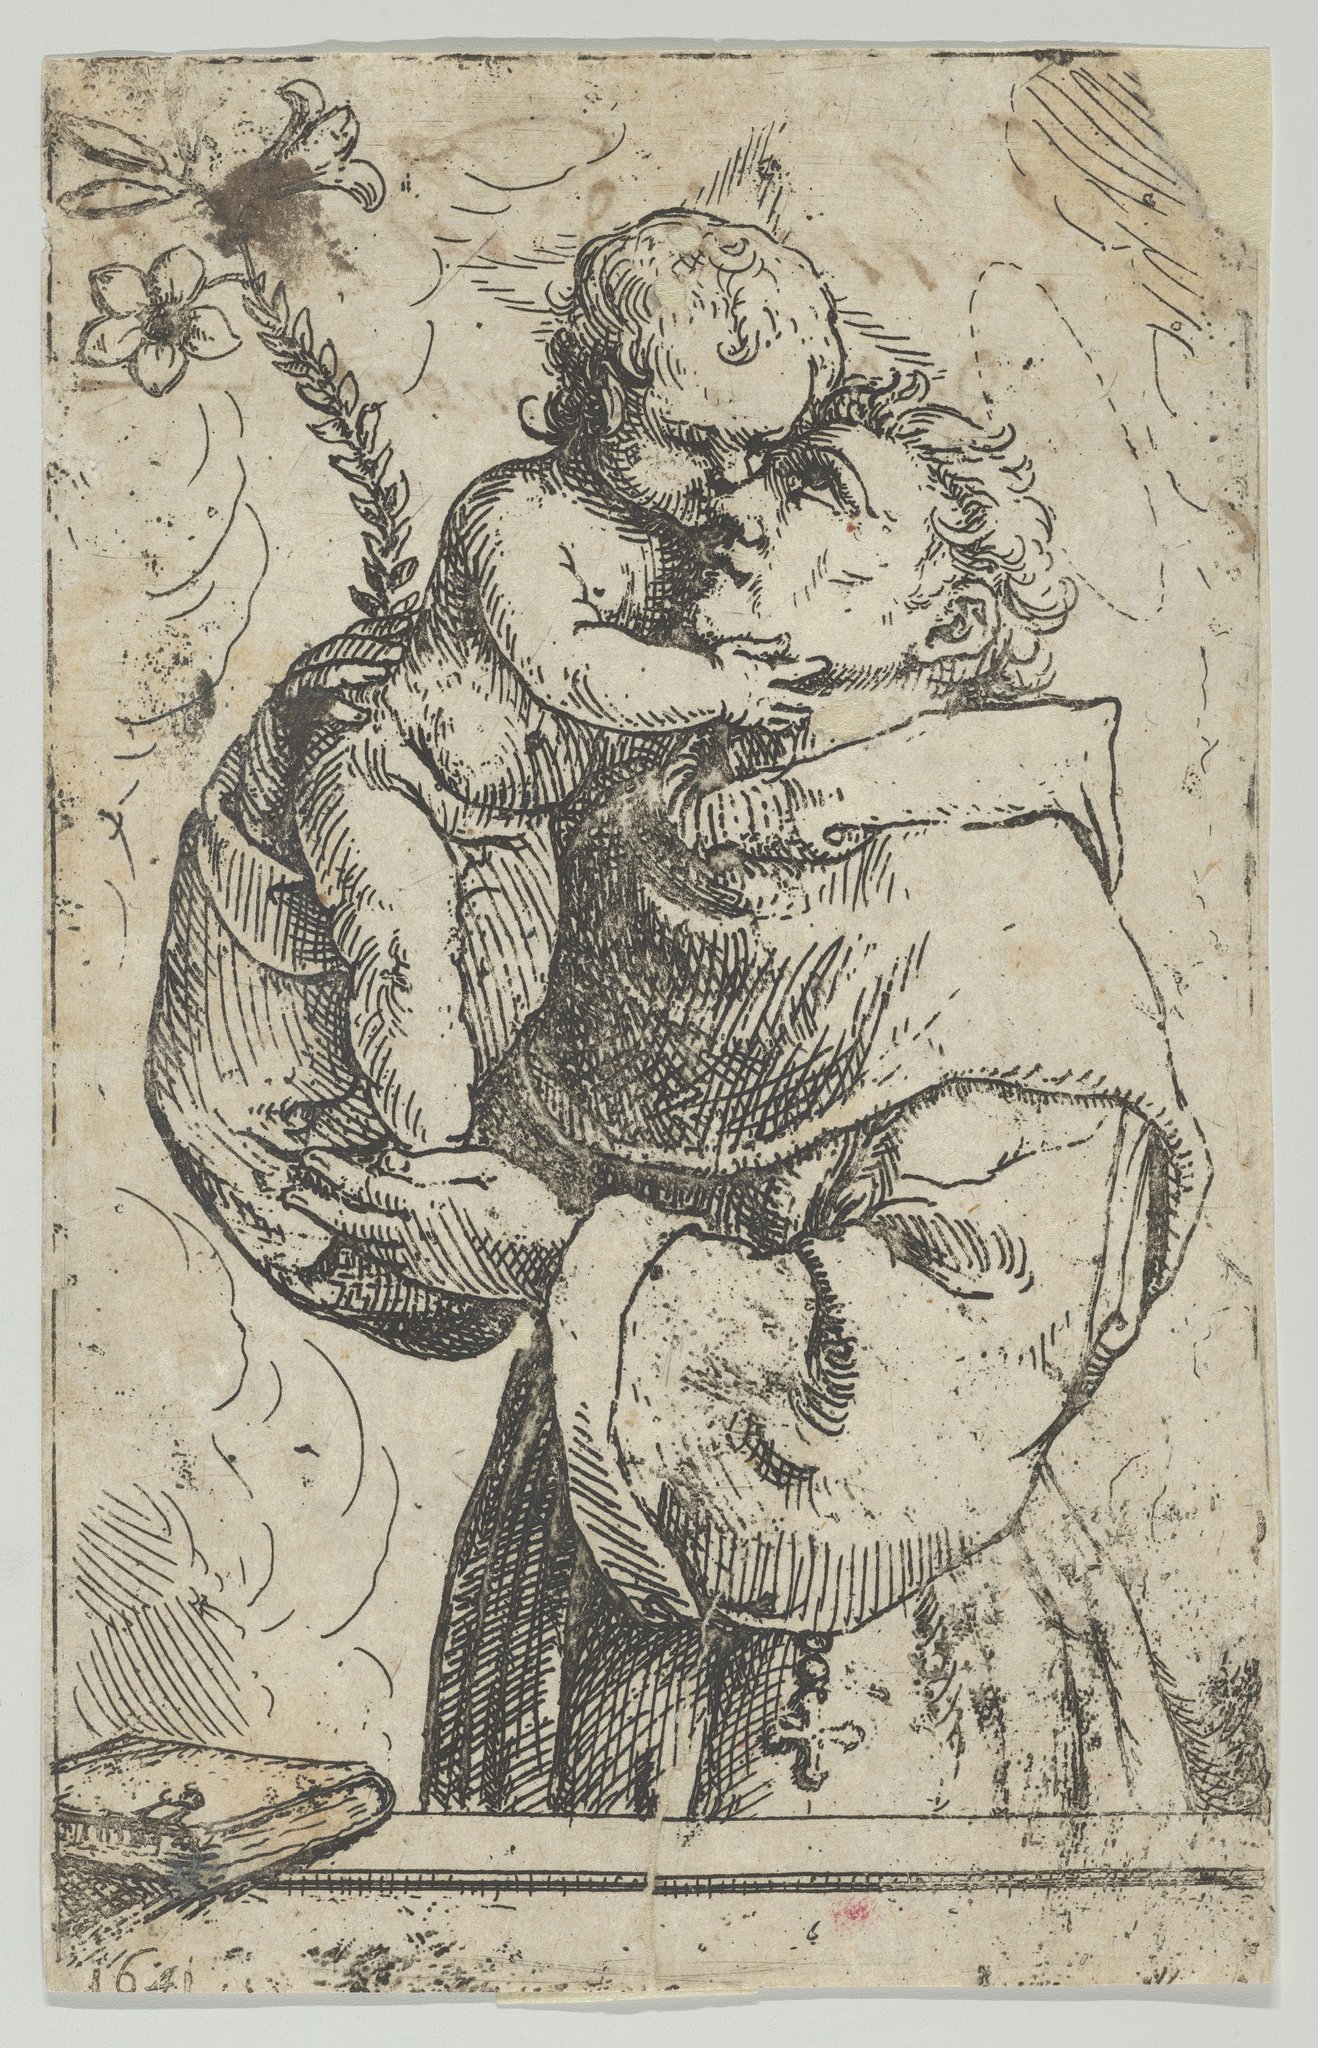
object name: print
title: St Antony of Padua embracing the Christ Child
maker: Anonymous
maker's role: artist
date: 1641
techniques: etching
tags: christ,saints